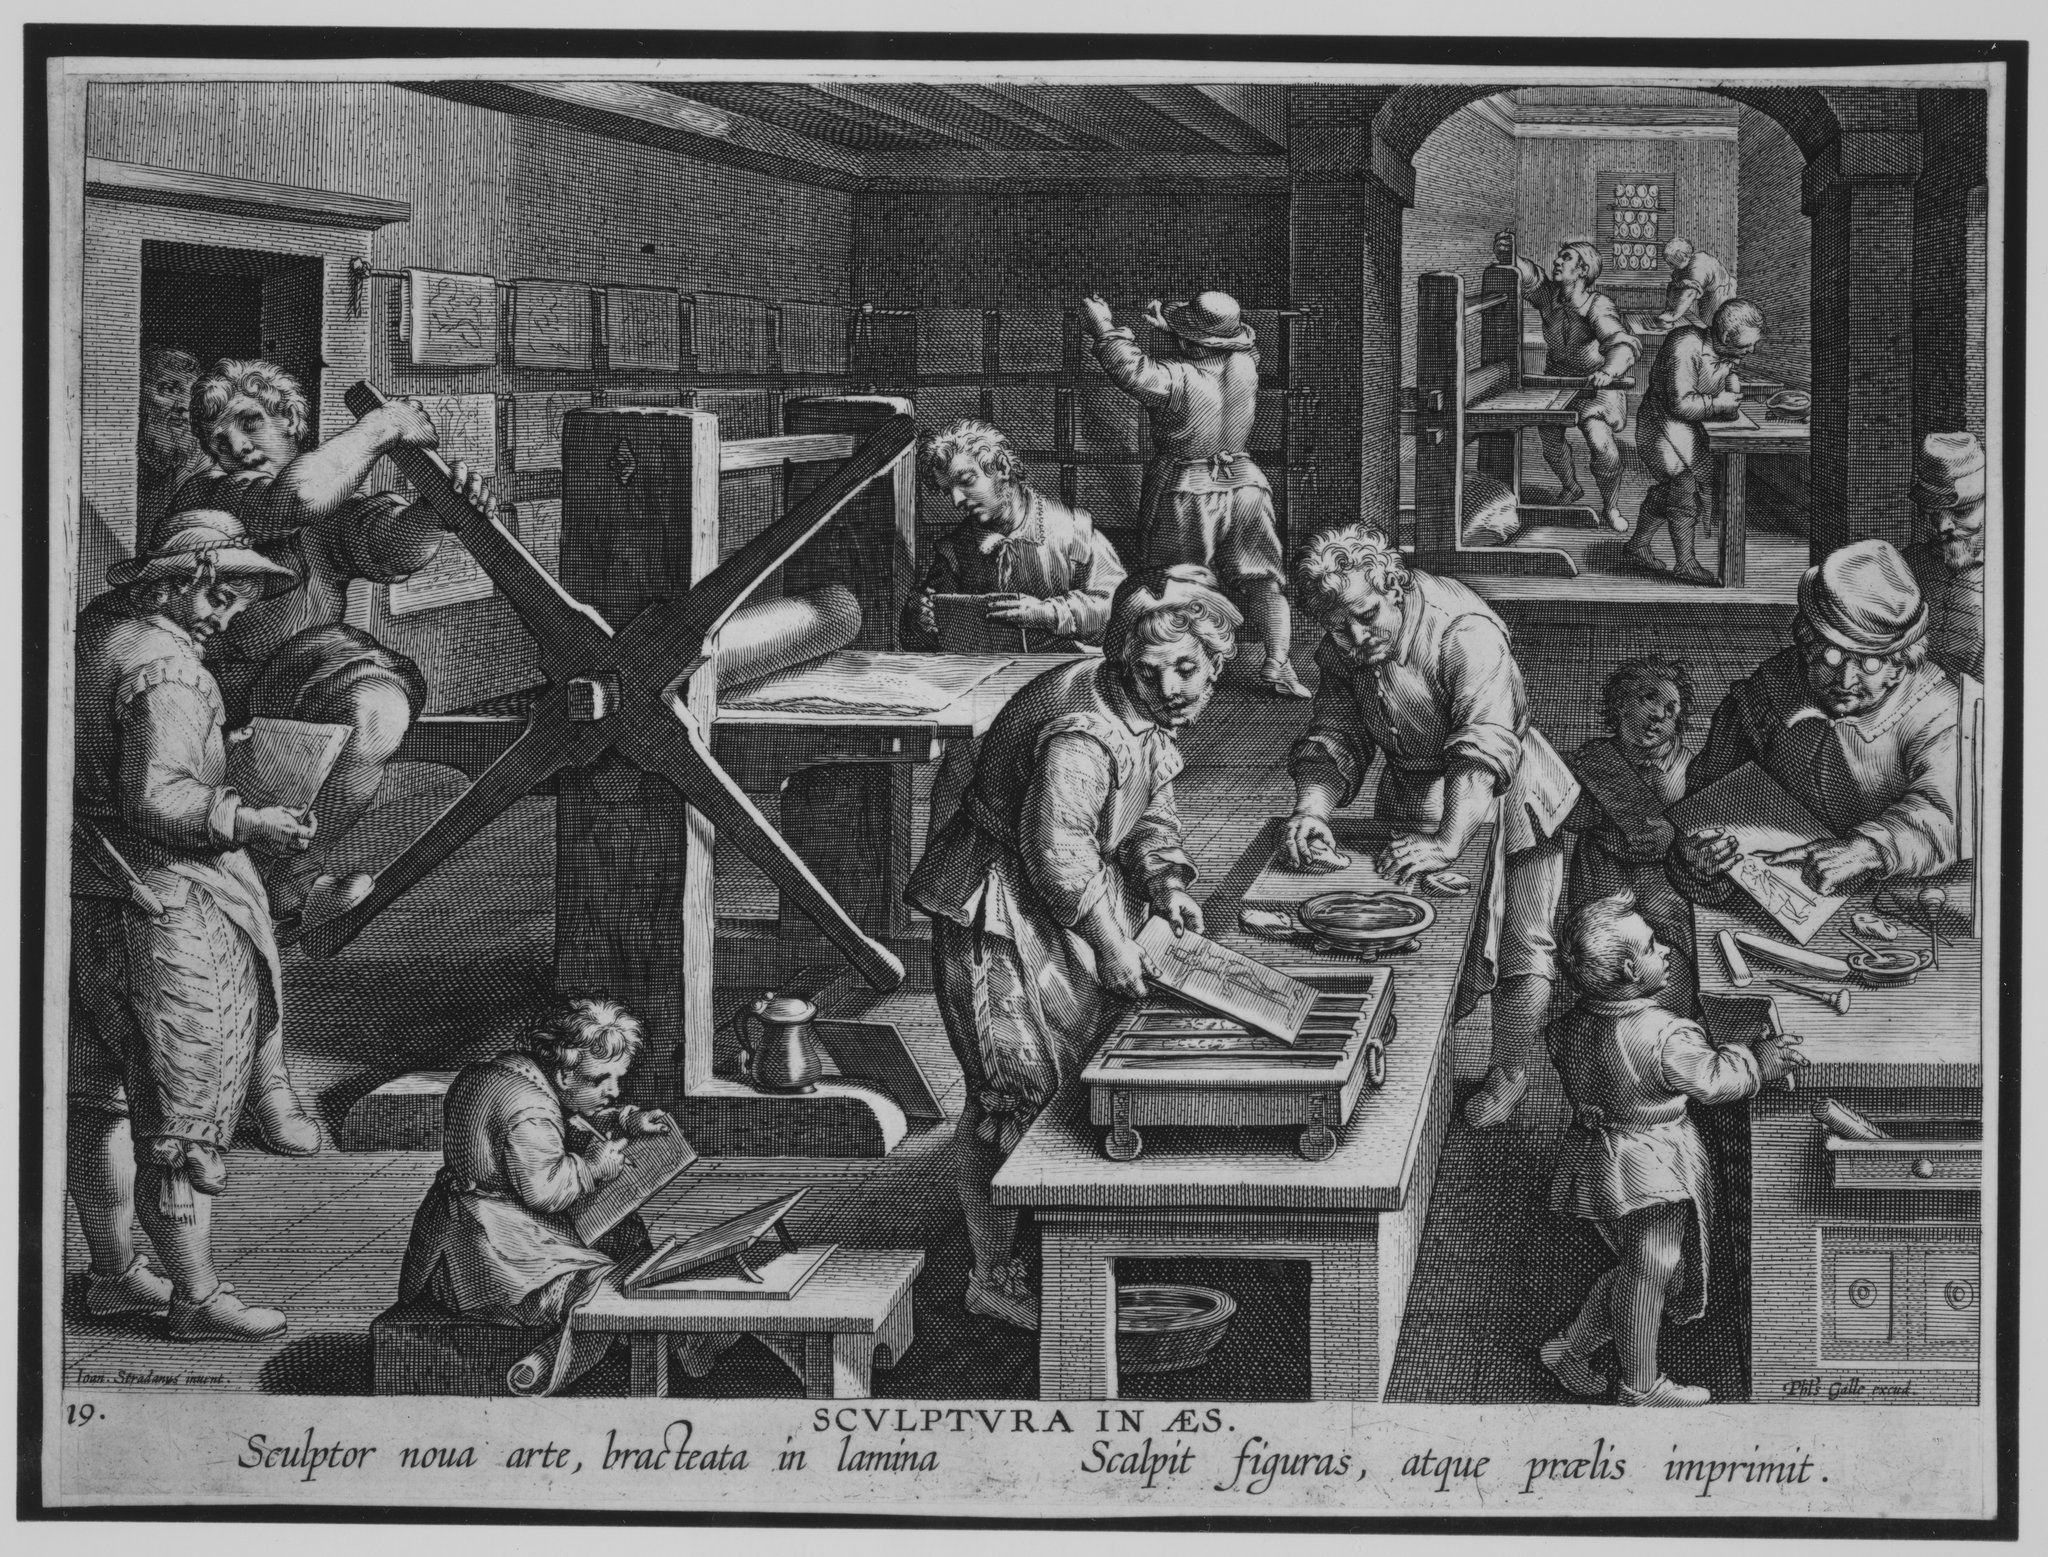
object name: print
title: The Workshop of an Engraver [Sculptura in Aes], plate 19 from Nova Reperta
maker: jan van der straet, called stradanus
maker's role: artist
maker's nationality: netherlandish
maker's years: 1523-1605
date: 1600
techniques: engraving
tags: boys,men,working